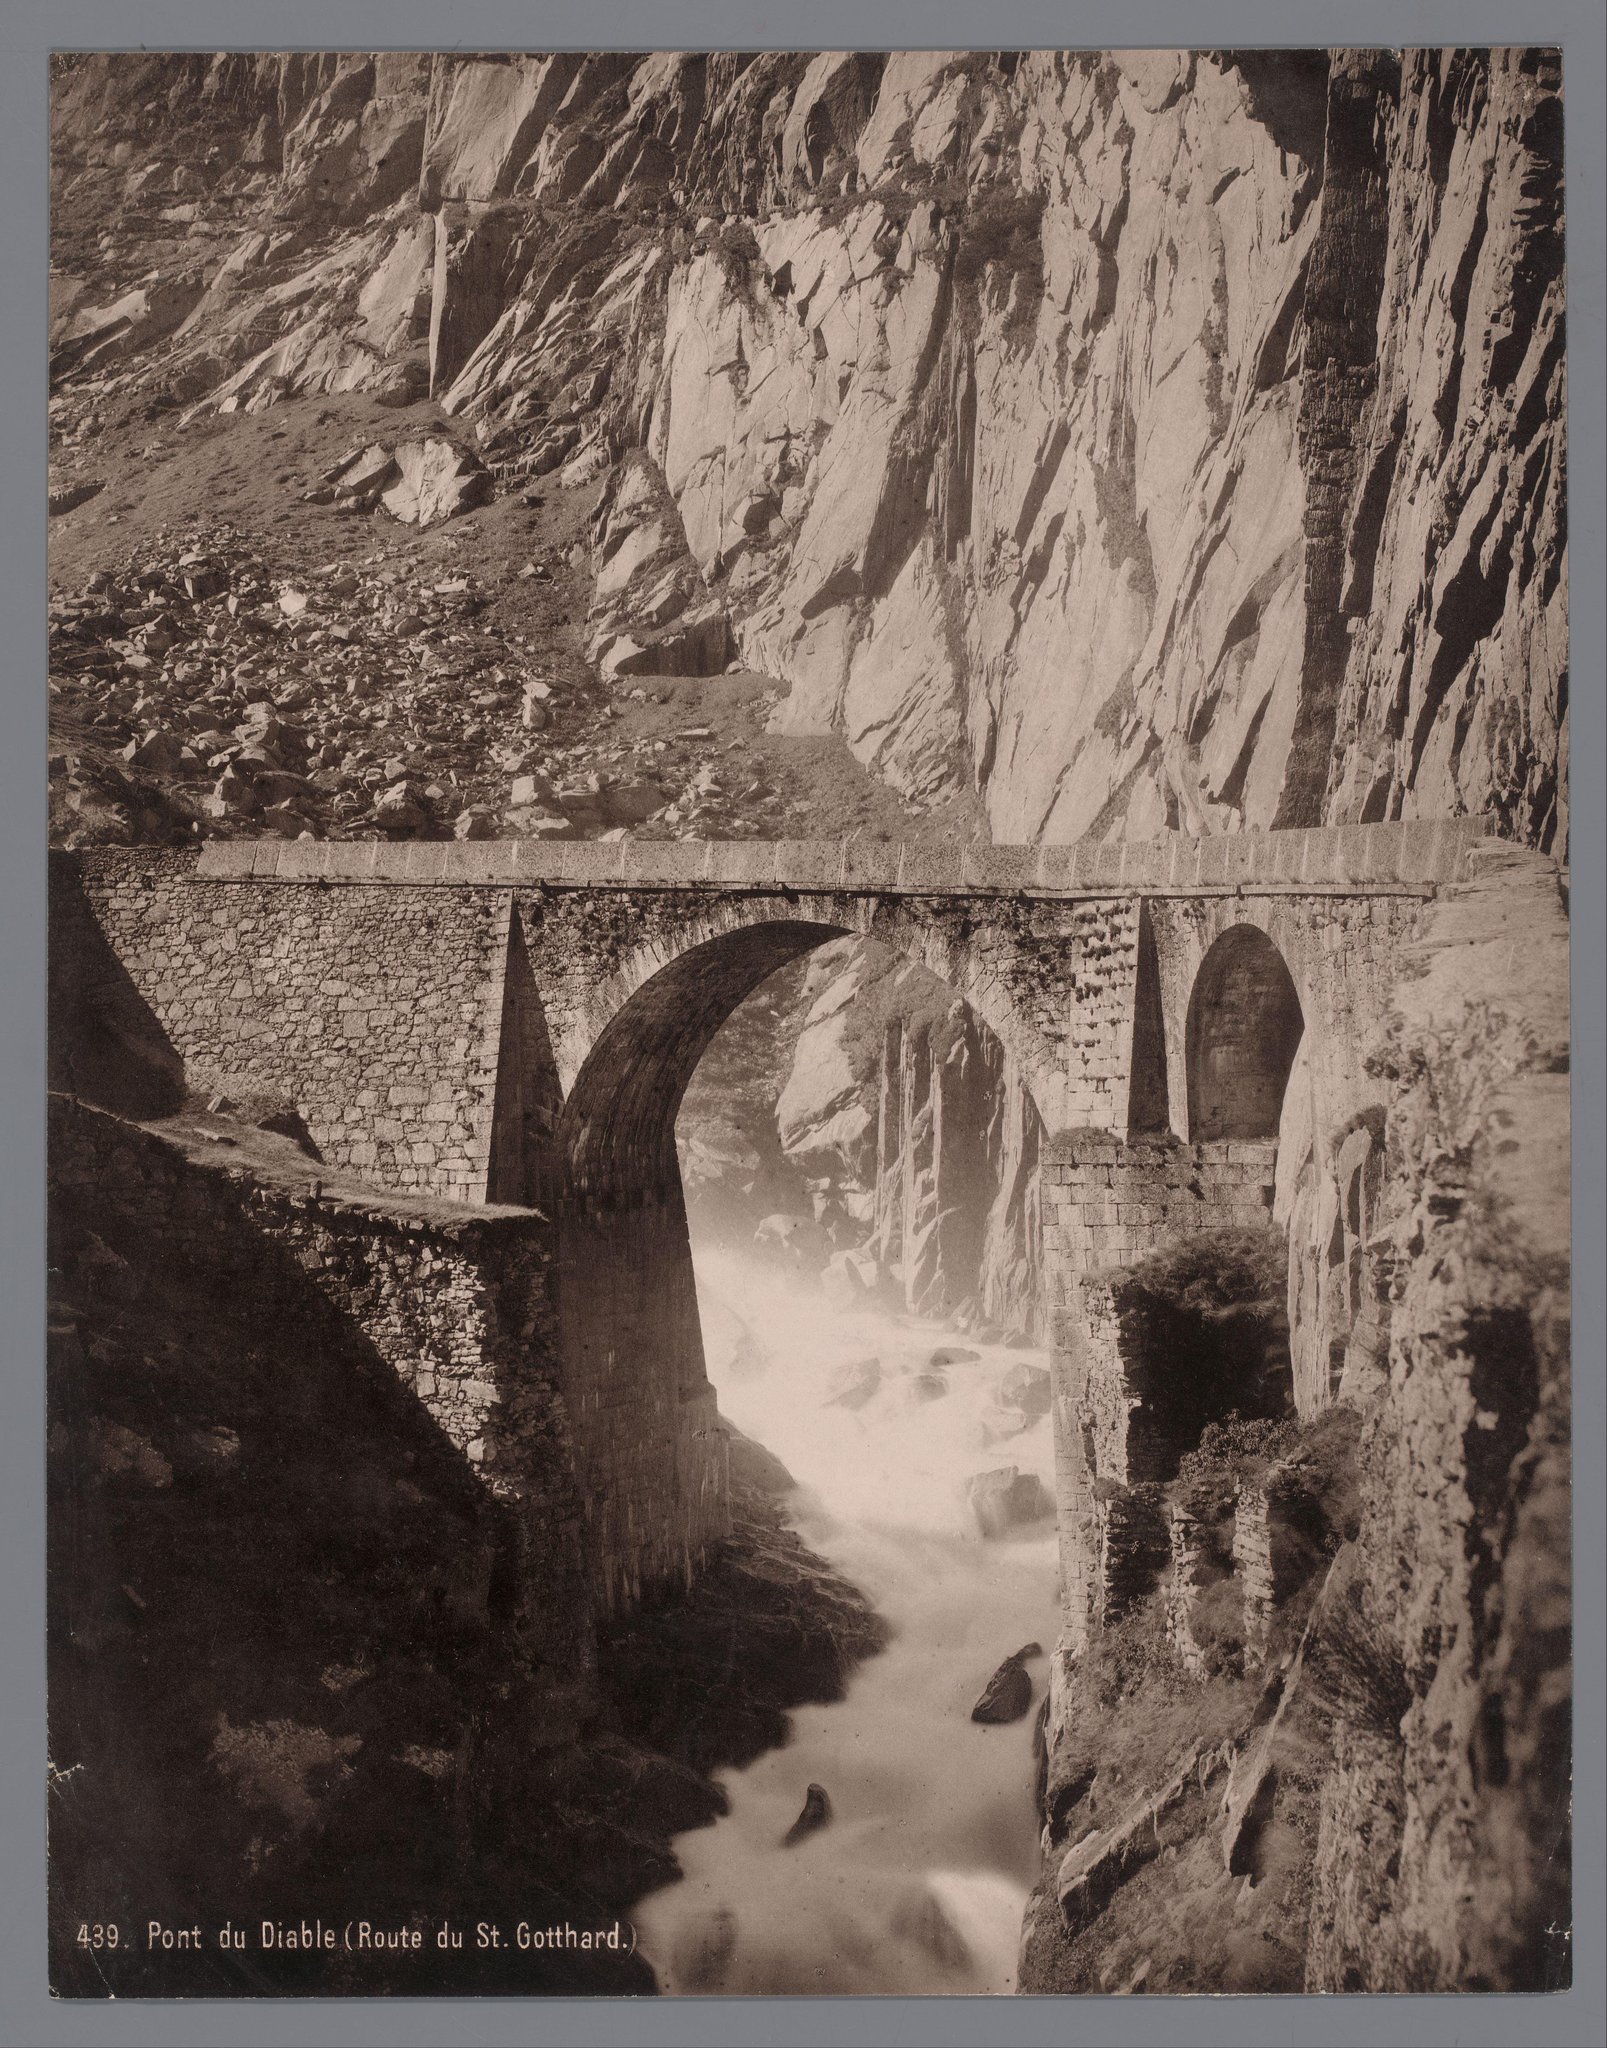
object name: photograph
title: Teufelsbrücke ["Pont du Diable"] over de Schöllenenschlucht, bij de Gotthardpas, Zwitserland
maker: Anonymous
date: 1890-1915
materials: paper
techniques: photoaquatint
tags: switzerland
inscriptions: inscription: ‘439. Pont du Diable (Route du St. Gotthard.)’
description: Brug over de Schöllenenschlucht, bij de Gotthardpass tussen Göschenen in het Noorden en Andermatt in het Zuiden (kanton Uri). Ertussen stroomt de rivier Reuss. De Gotthardpas verbindt kanton Uri met kanton Tessin.